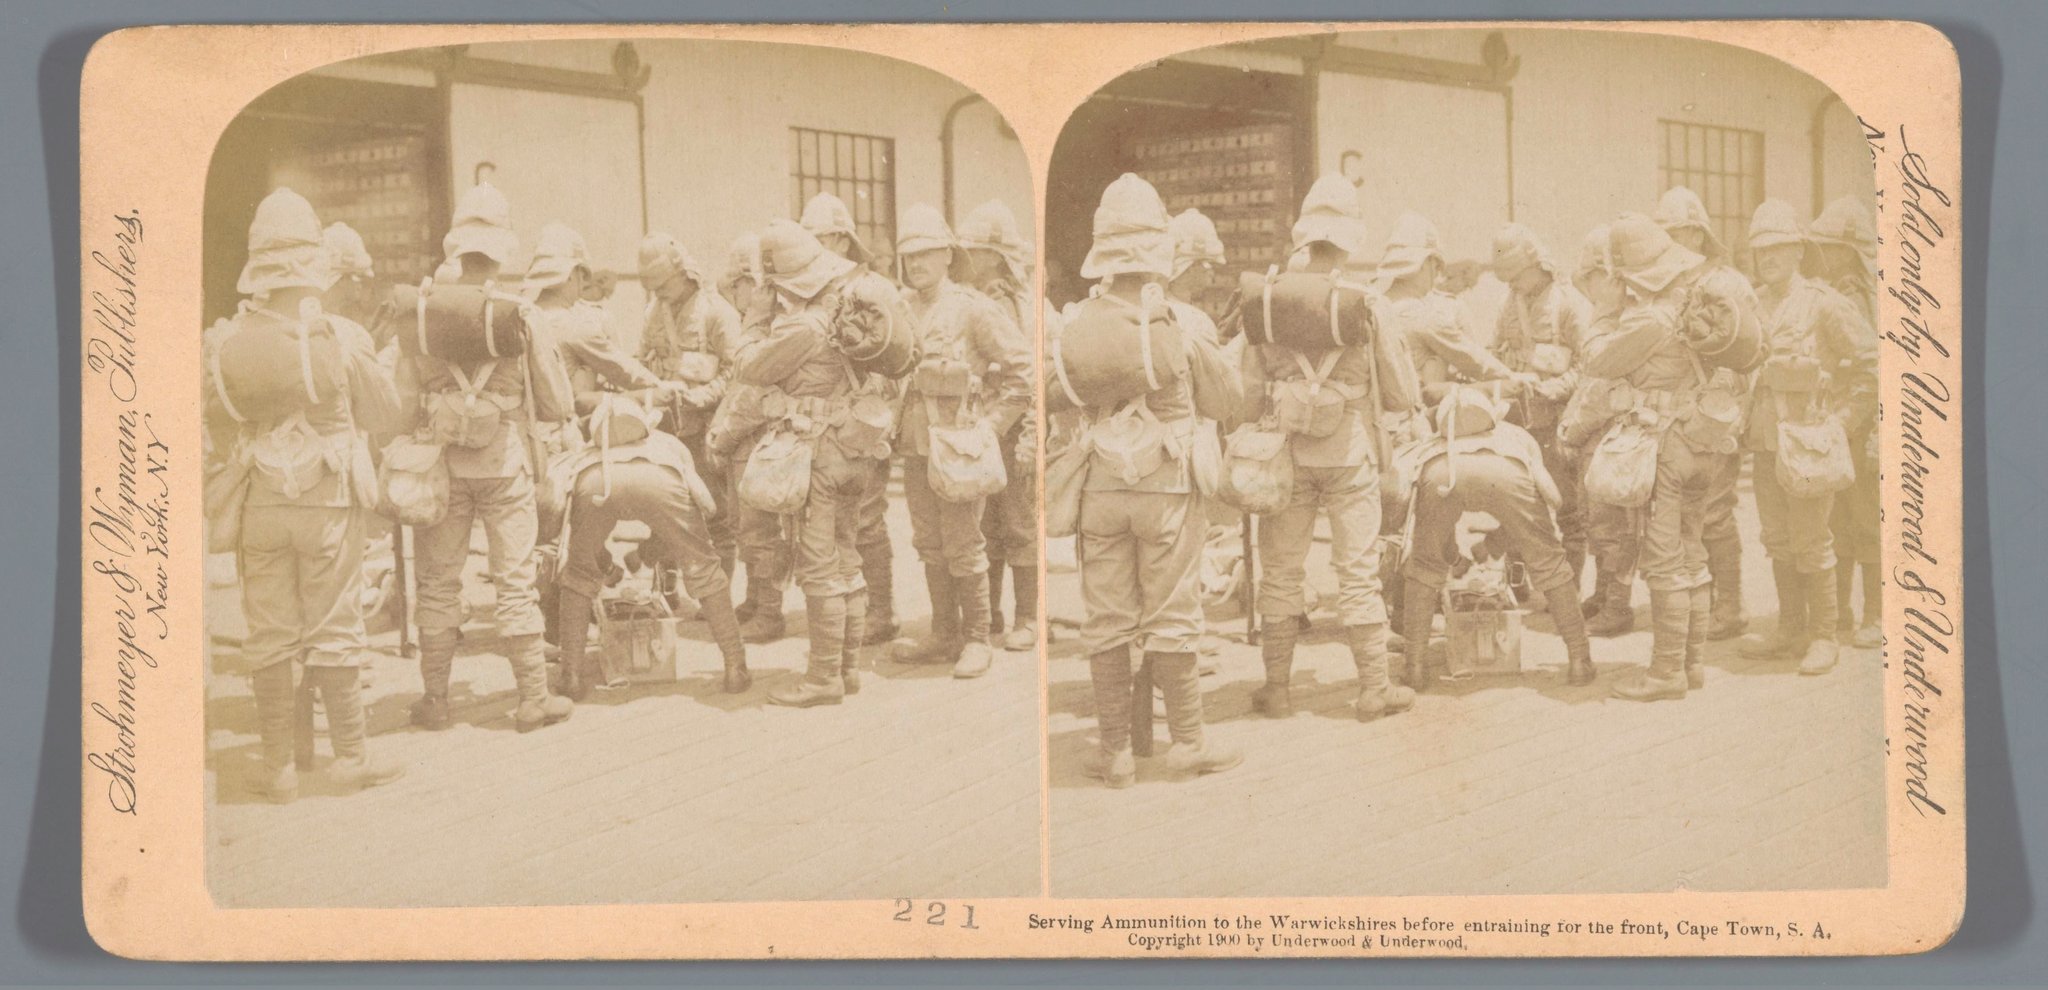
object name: stereograph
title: Serving Ammunition to the Warwickshires before entraining for the front, Cape Town, S.A.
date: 1900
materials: cardboard, photographic support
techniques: albumen print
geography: new york city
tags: ammunition, the soldier; the soldier's life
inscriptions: number: ‘221’